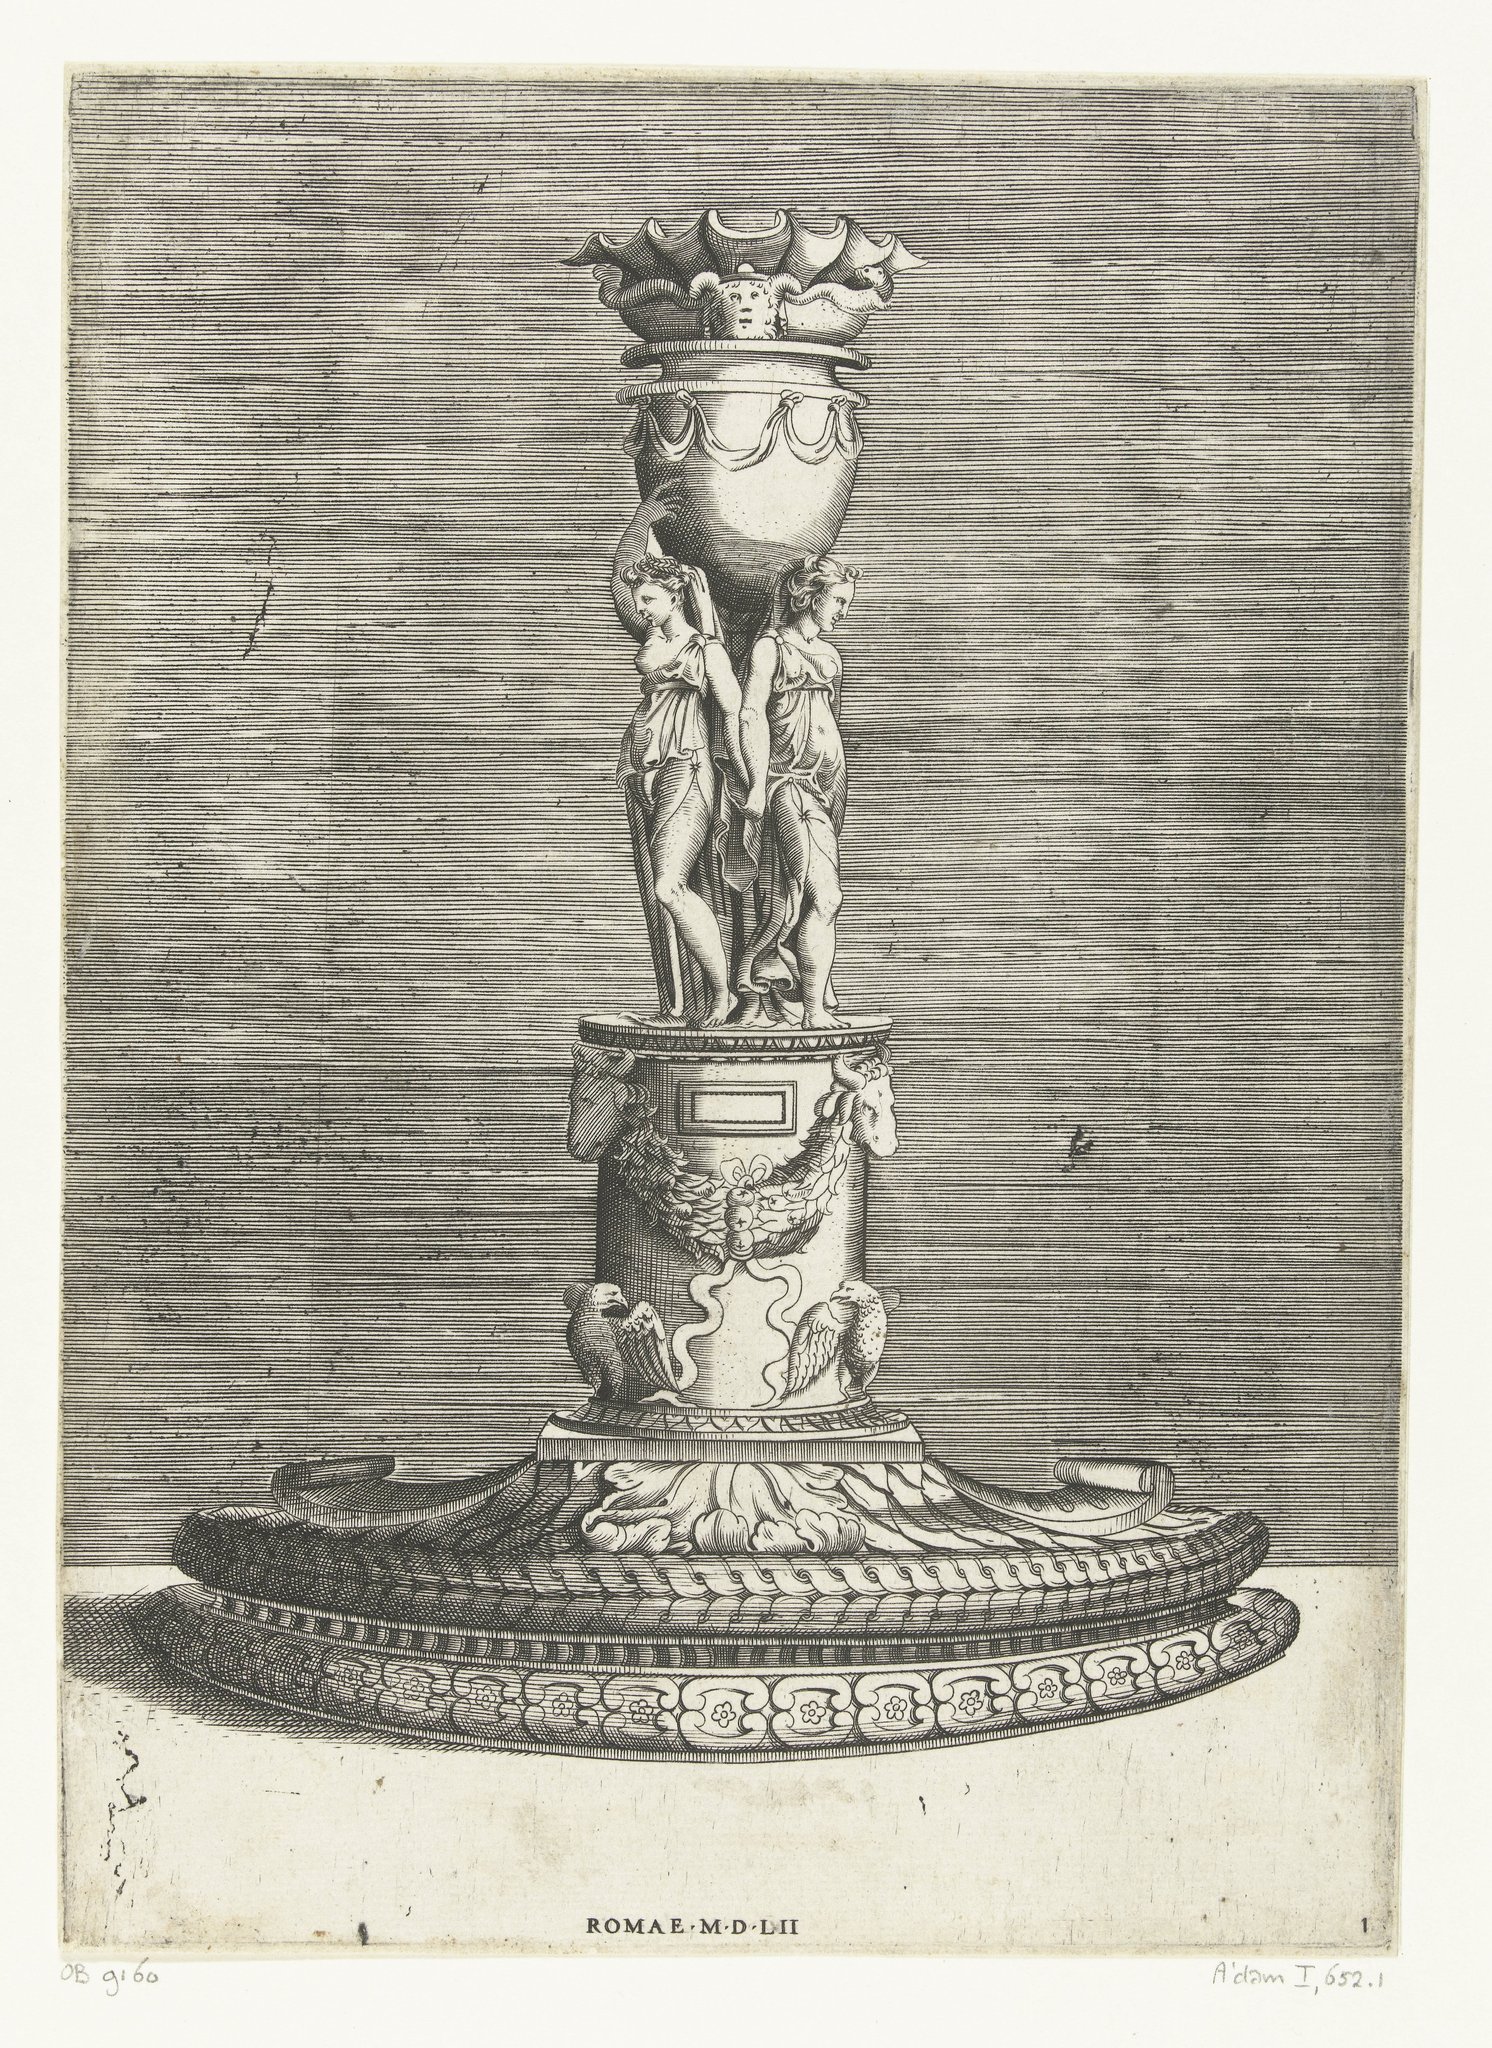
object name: ornament print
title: Kandelaars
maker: Anonymous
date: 1552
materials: paper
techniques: engraving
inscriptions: collector's mark: Lugt 240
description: Kandelaar met een ronde voet waarop een sokkel staat, gedecoreerd met vogels, guirlandes en mascarons. Op de sokkel staan kariatiden die de vaasvormige kaarshouder dragen. Horizontaal gearceerde achtergrond. Tegenzijdige kopie naar door Enea Vico gegraveerde kandelaars.